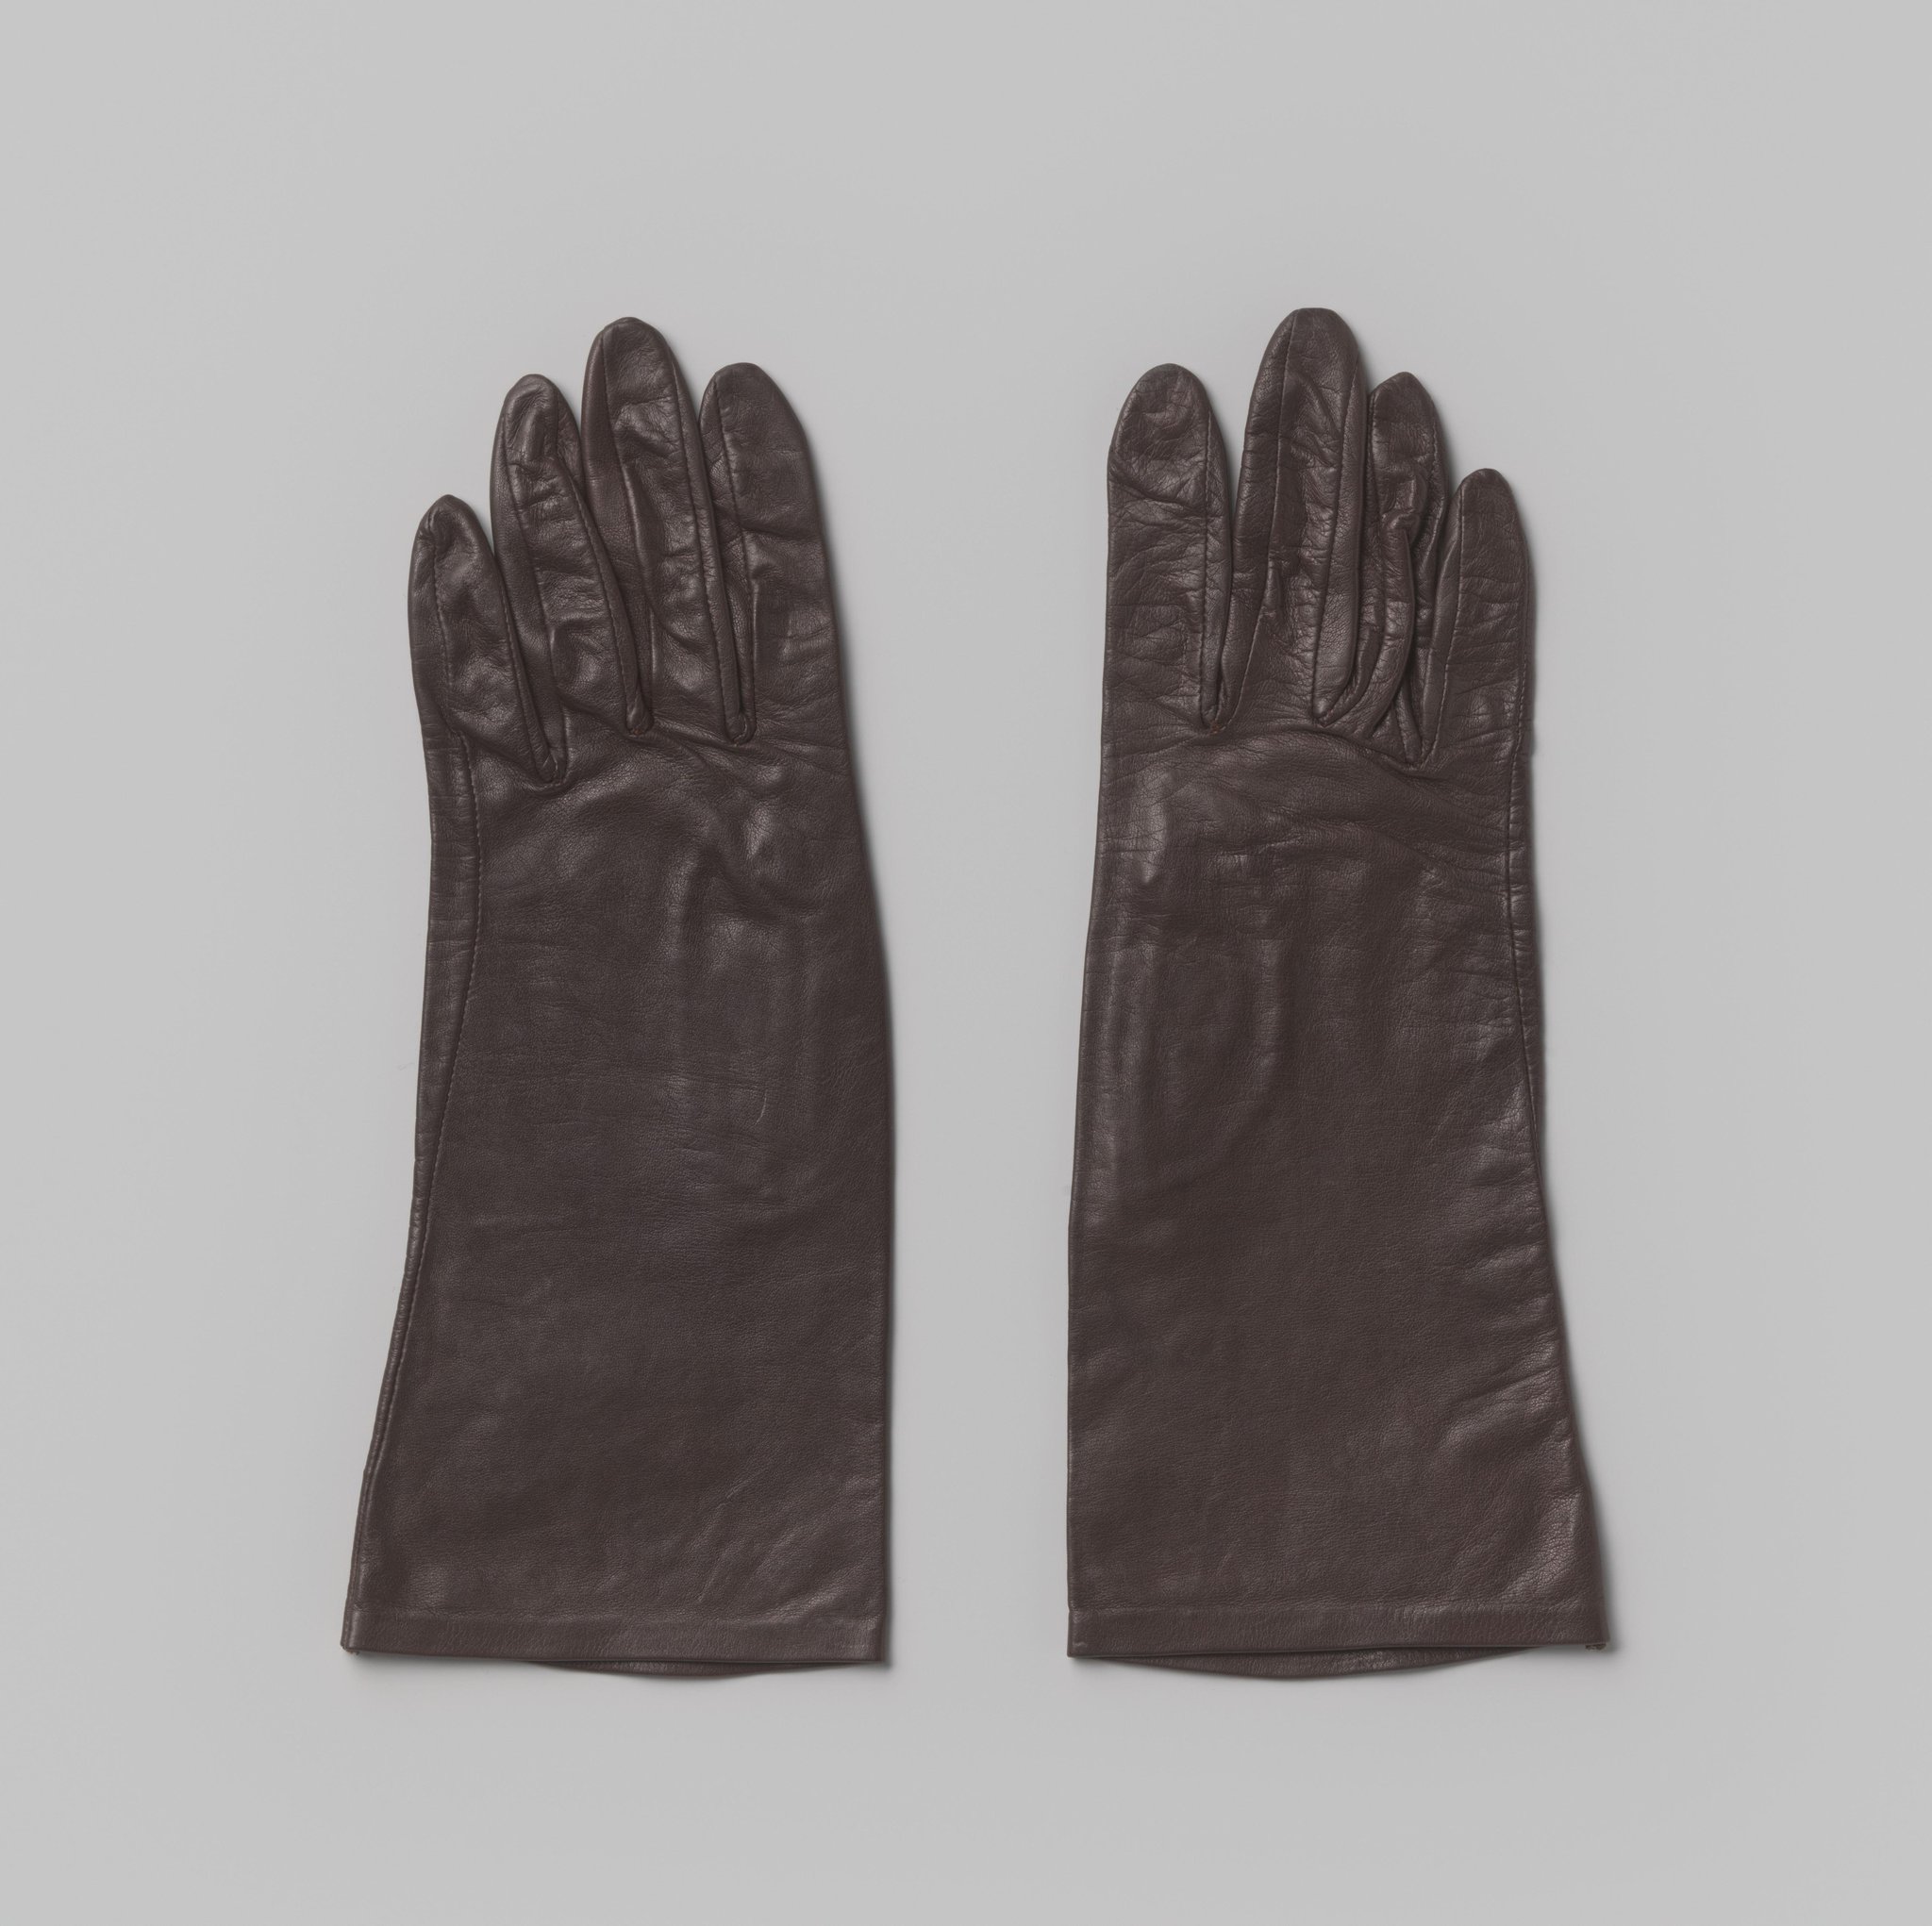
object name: glove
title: Handschoen van donkerbruin glacéleer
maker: Anonymous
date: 1960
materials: leather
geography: amsterdam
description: Linker handschoen, van bruin glacéleer. Model: kort, met omgezoomde entree. Geen versieringsnaden. Amsterdam, ca. 1960.